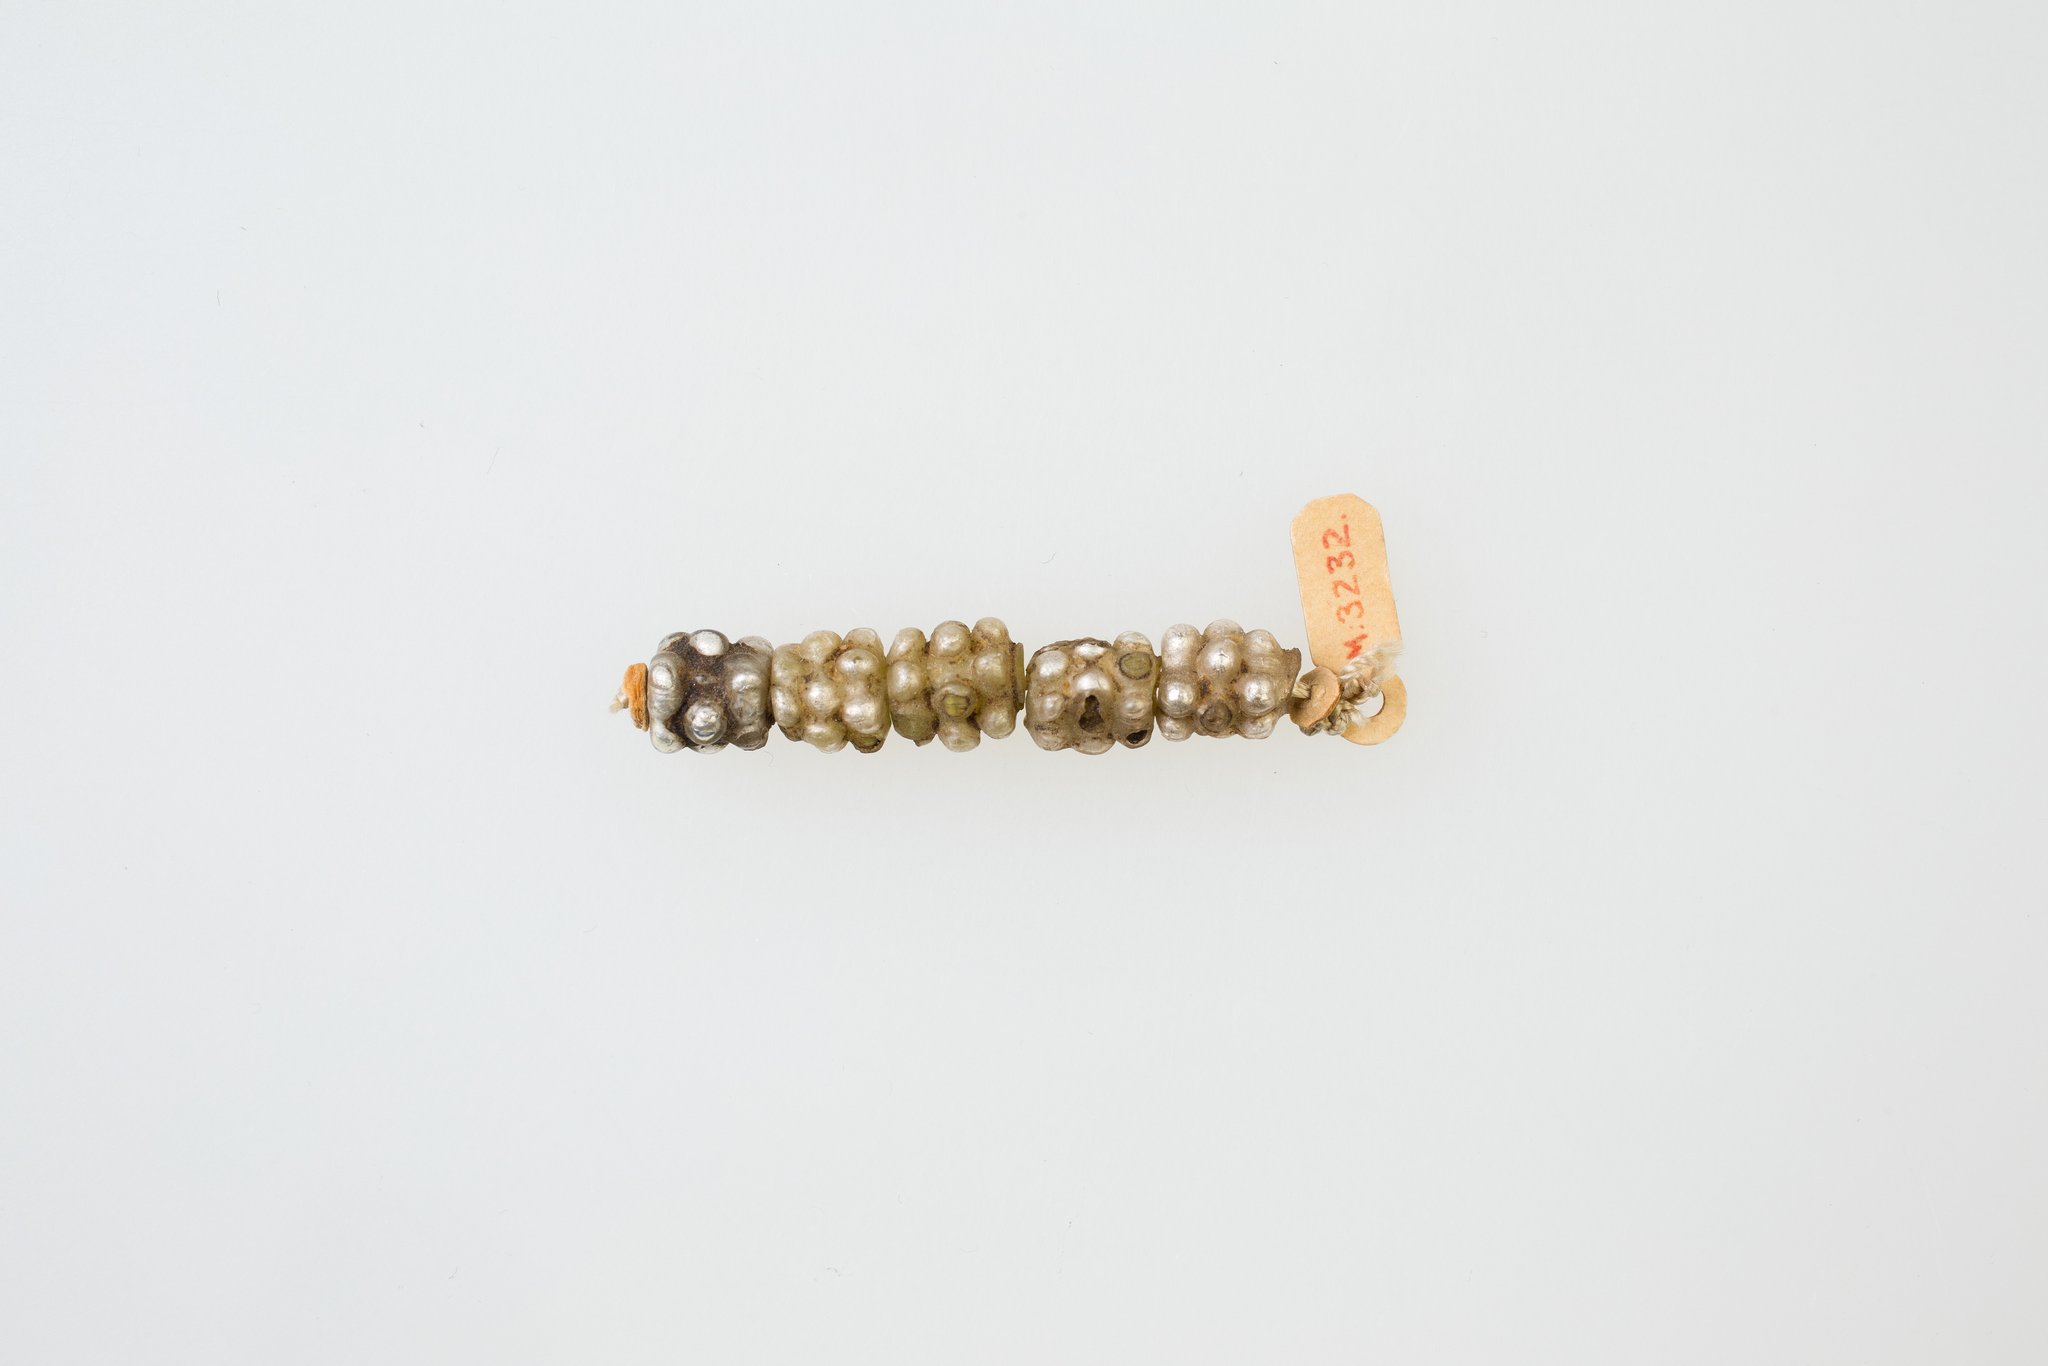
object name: bead, knobbed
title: String of 5 knobbed beads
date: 200 BCE-200 CE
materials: glass, gold foil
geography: egypt